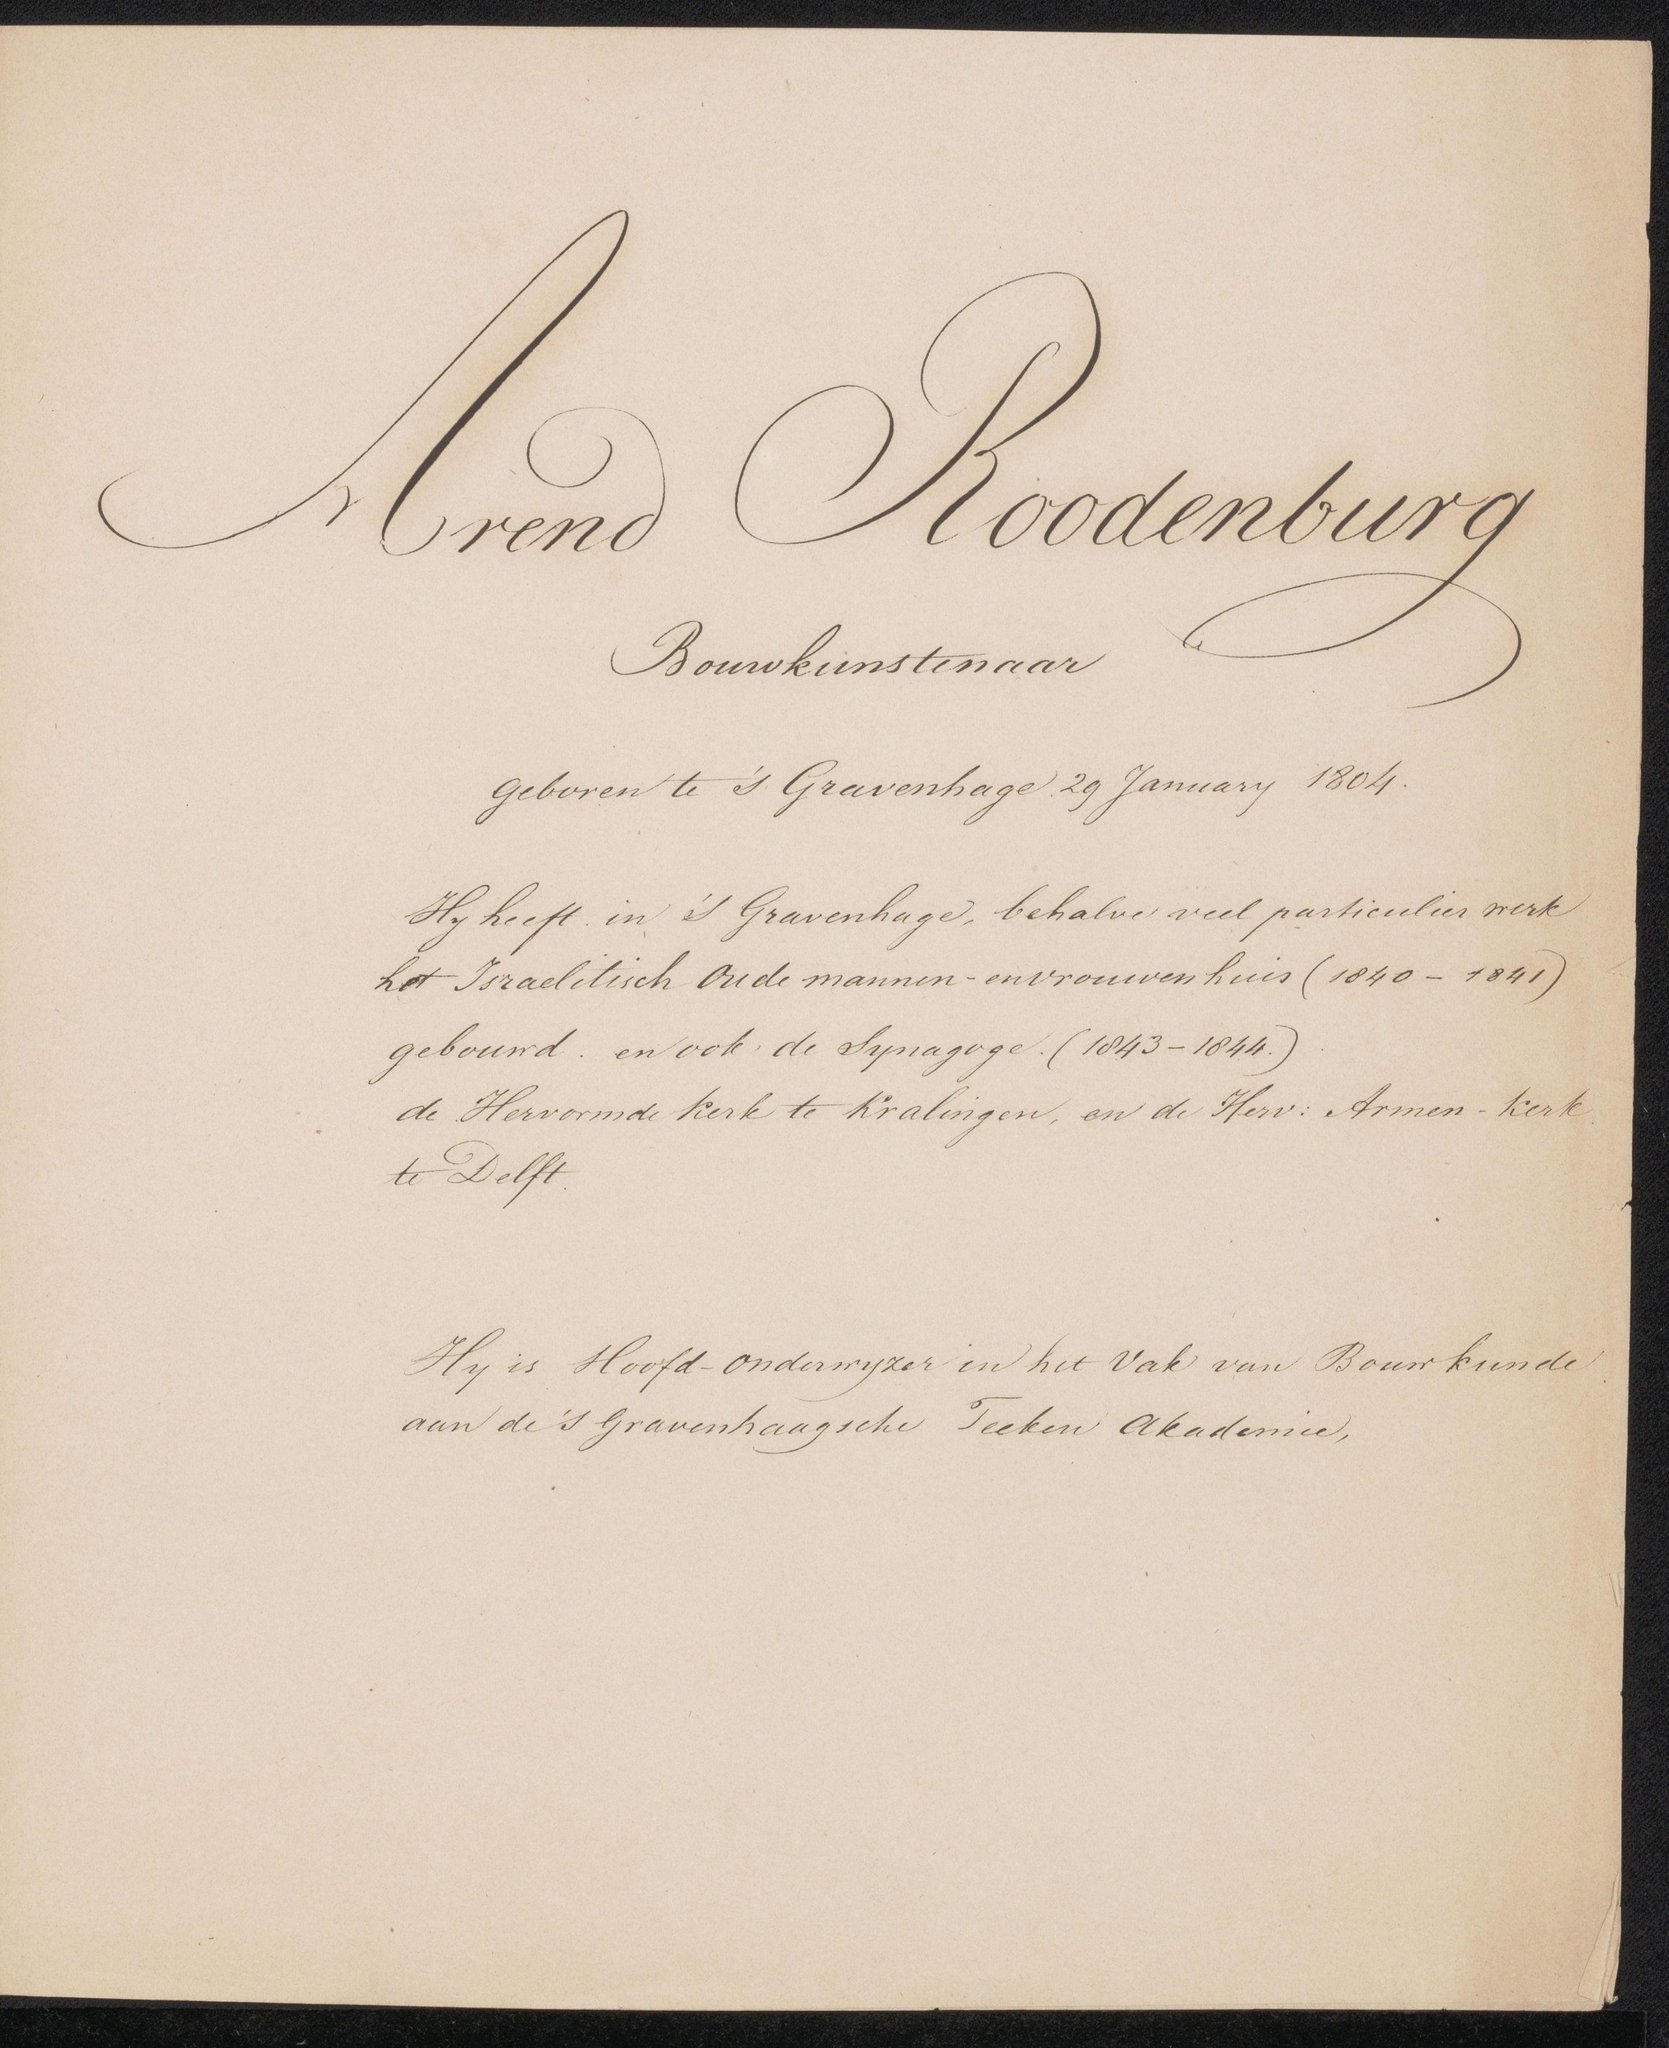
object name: document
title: Document betreffende Arend Roodenburg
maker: Anonymous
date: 1844-1884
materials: ink, paper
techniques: pen, writing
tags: draughtsman, arend roodenburg, education, tuition of the artist (in general), architecture, the hague, delft